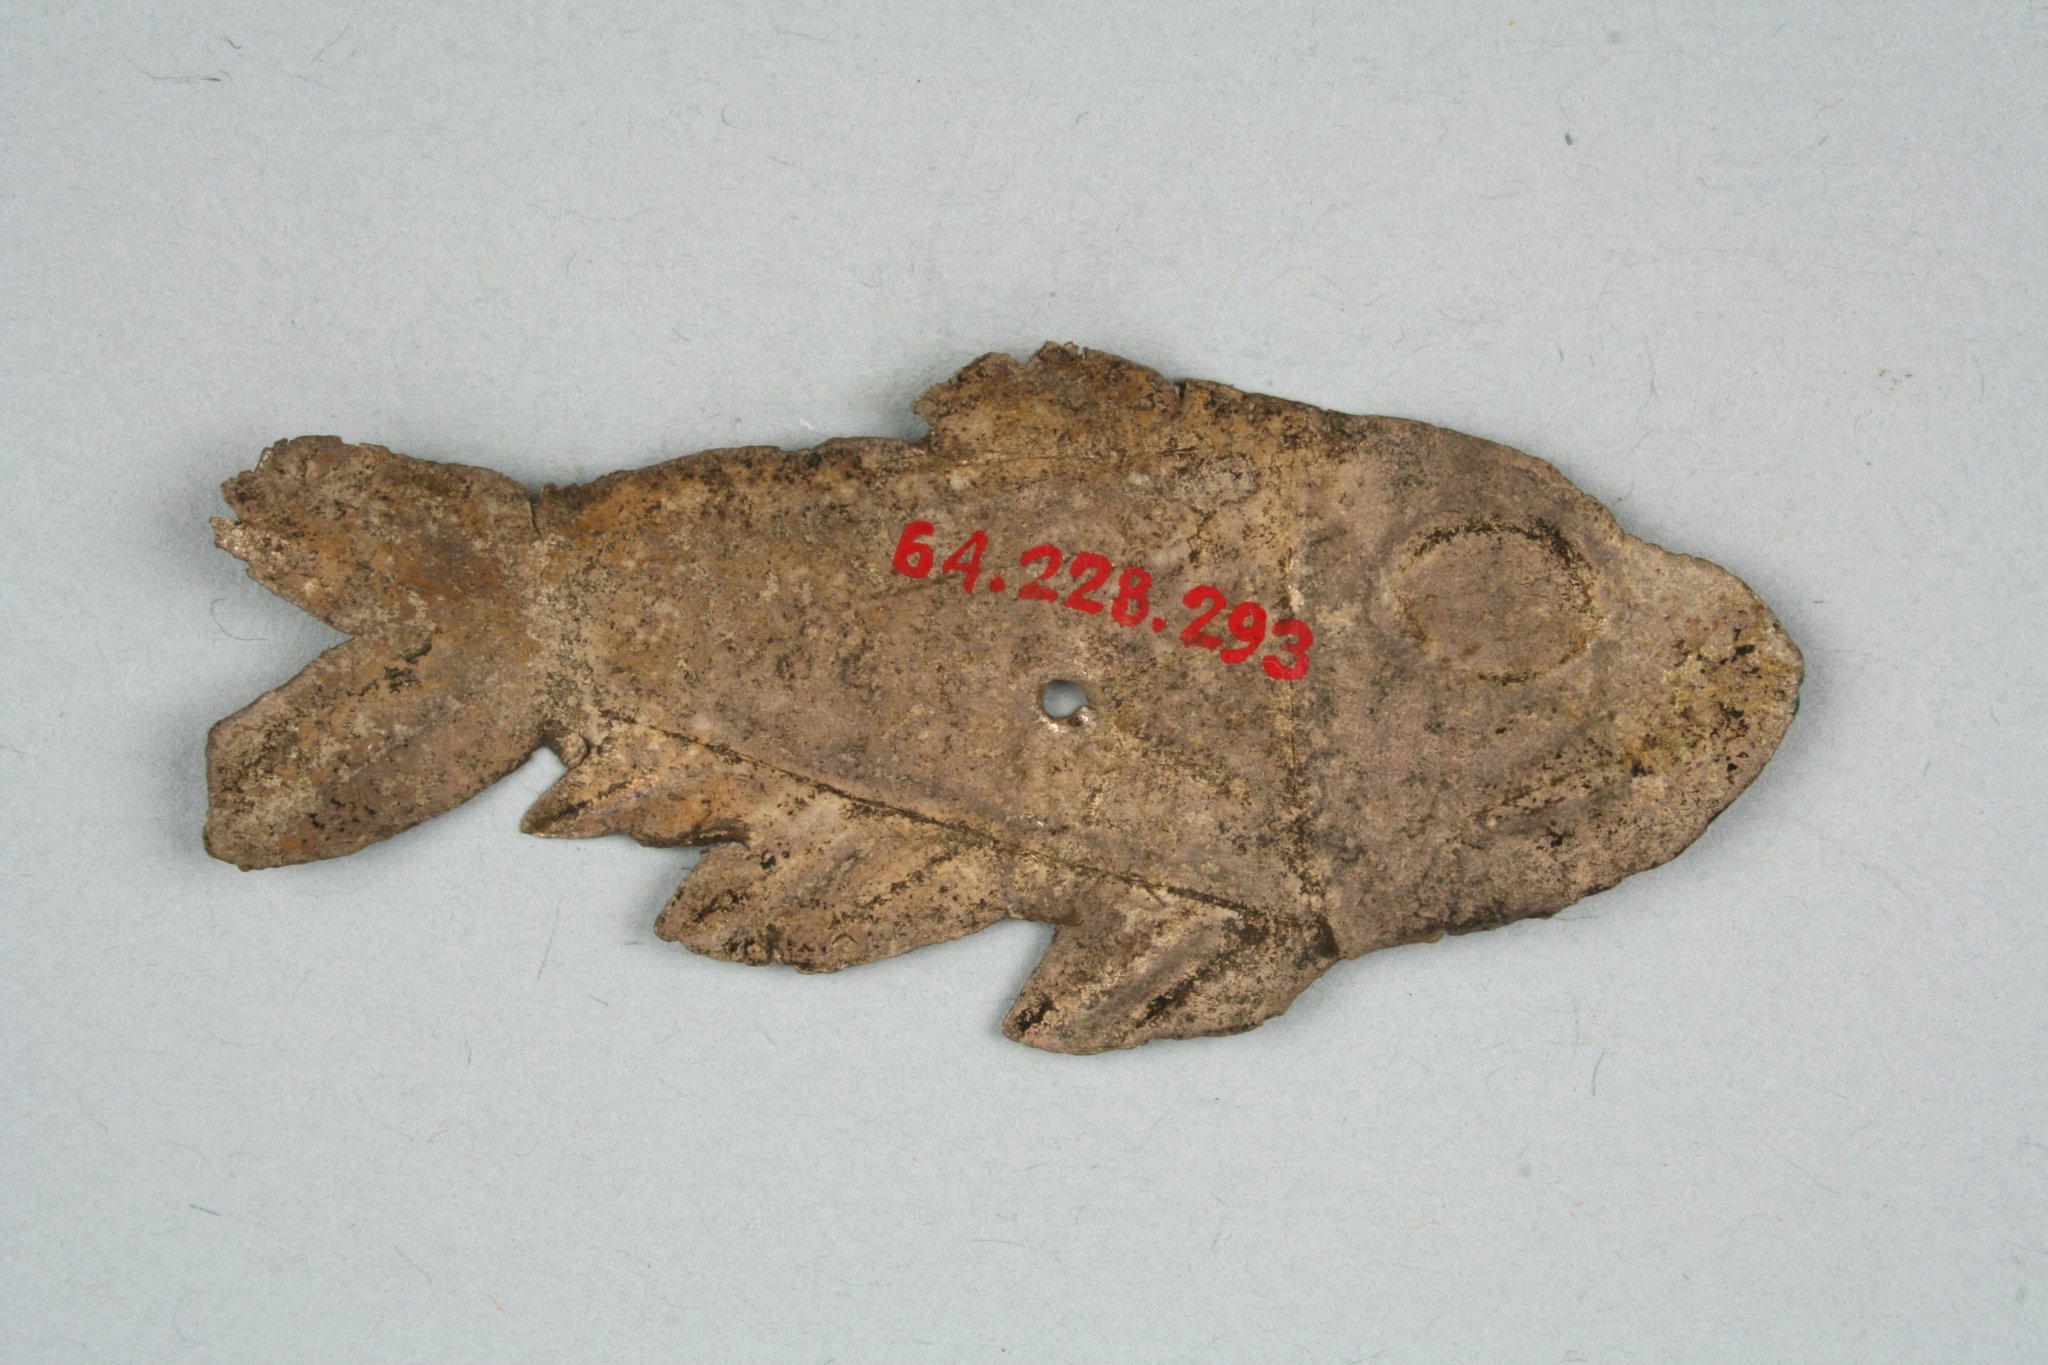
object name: costume ornament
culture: peruvian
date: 1001-1200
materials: silver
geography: peru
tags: fish